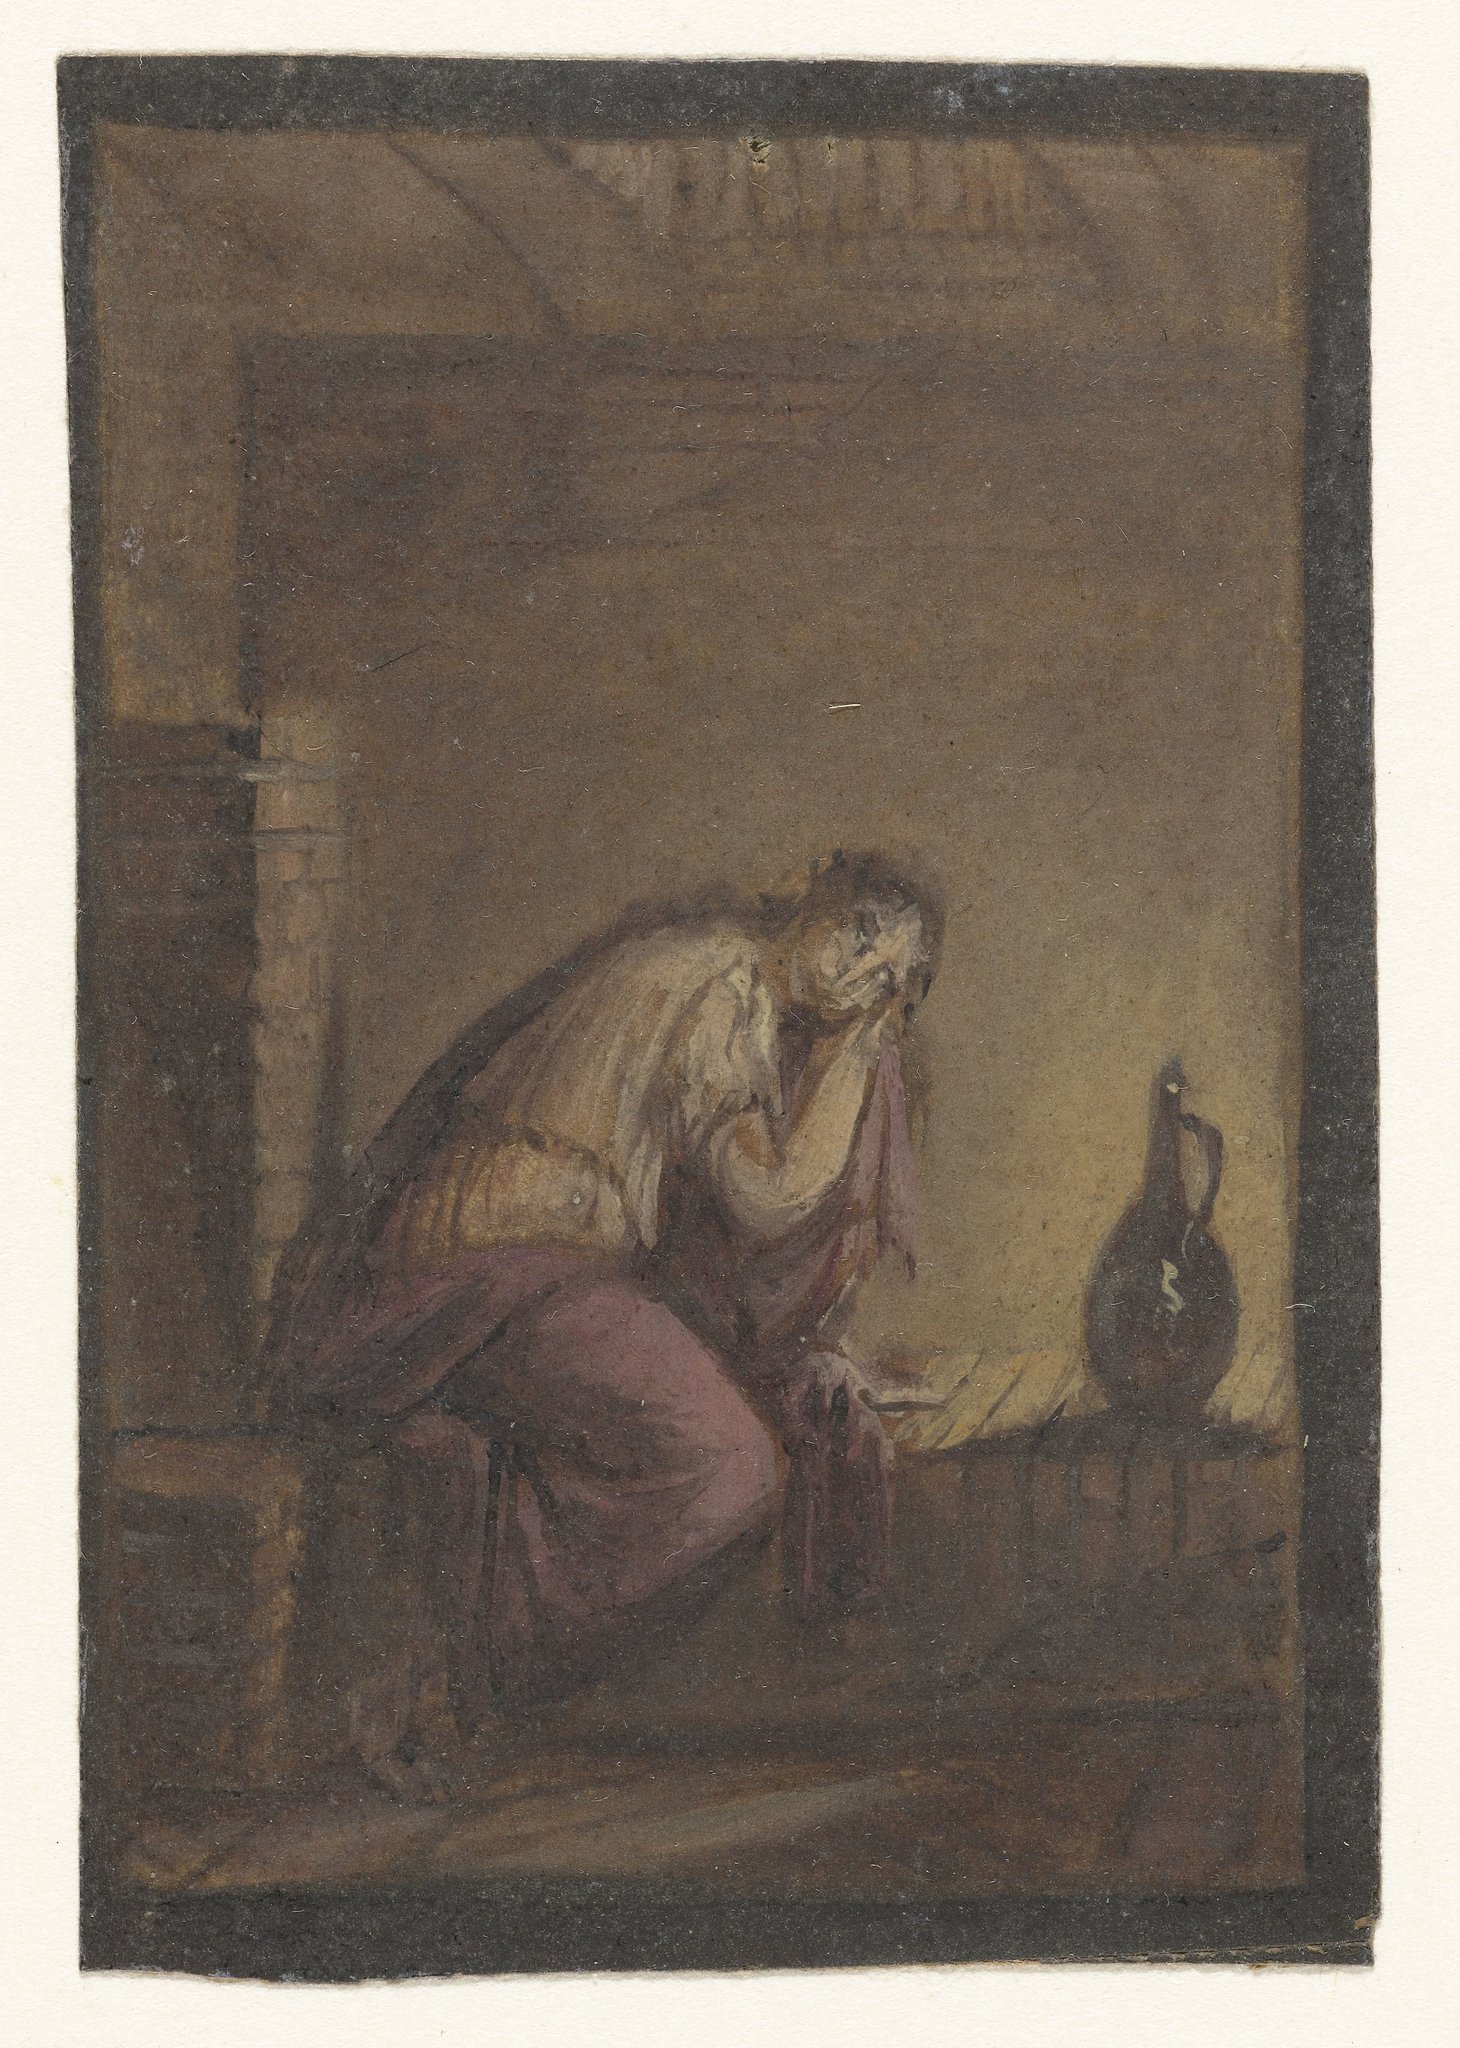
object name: drawing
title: Zittende vrouw met kruik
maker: Anonymous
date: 1700-1800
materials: oil, paper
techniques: brush